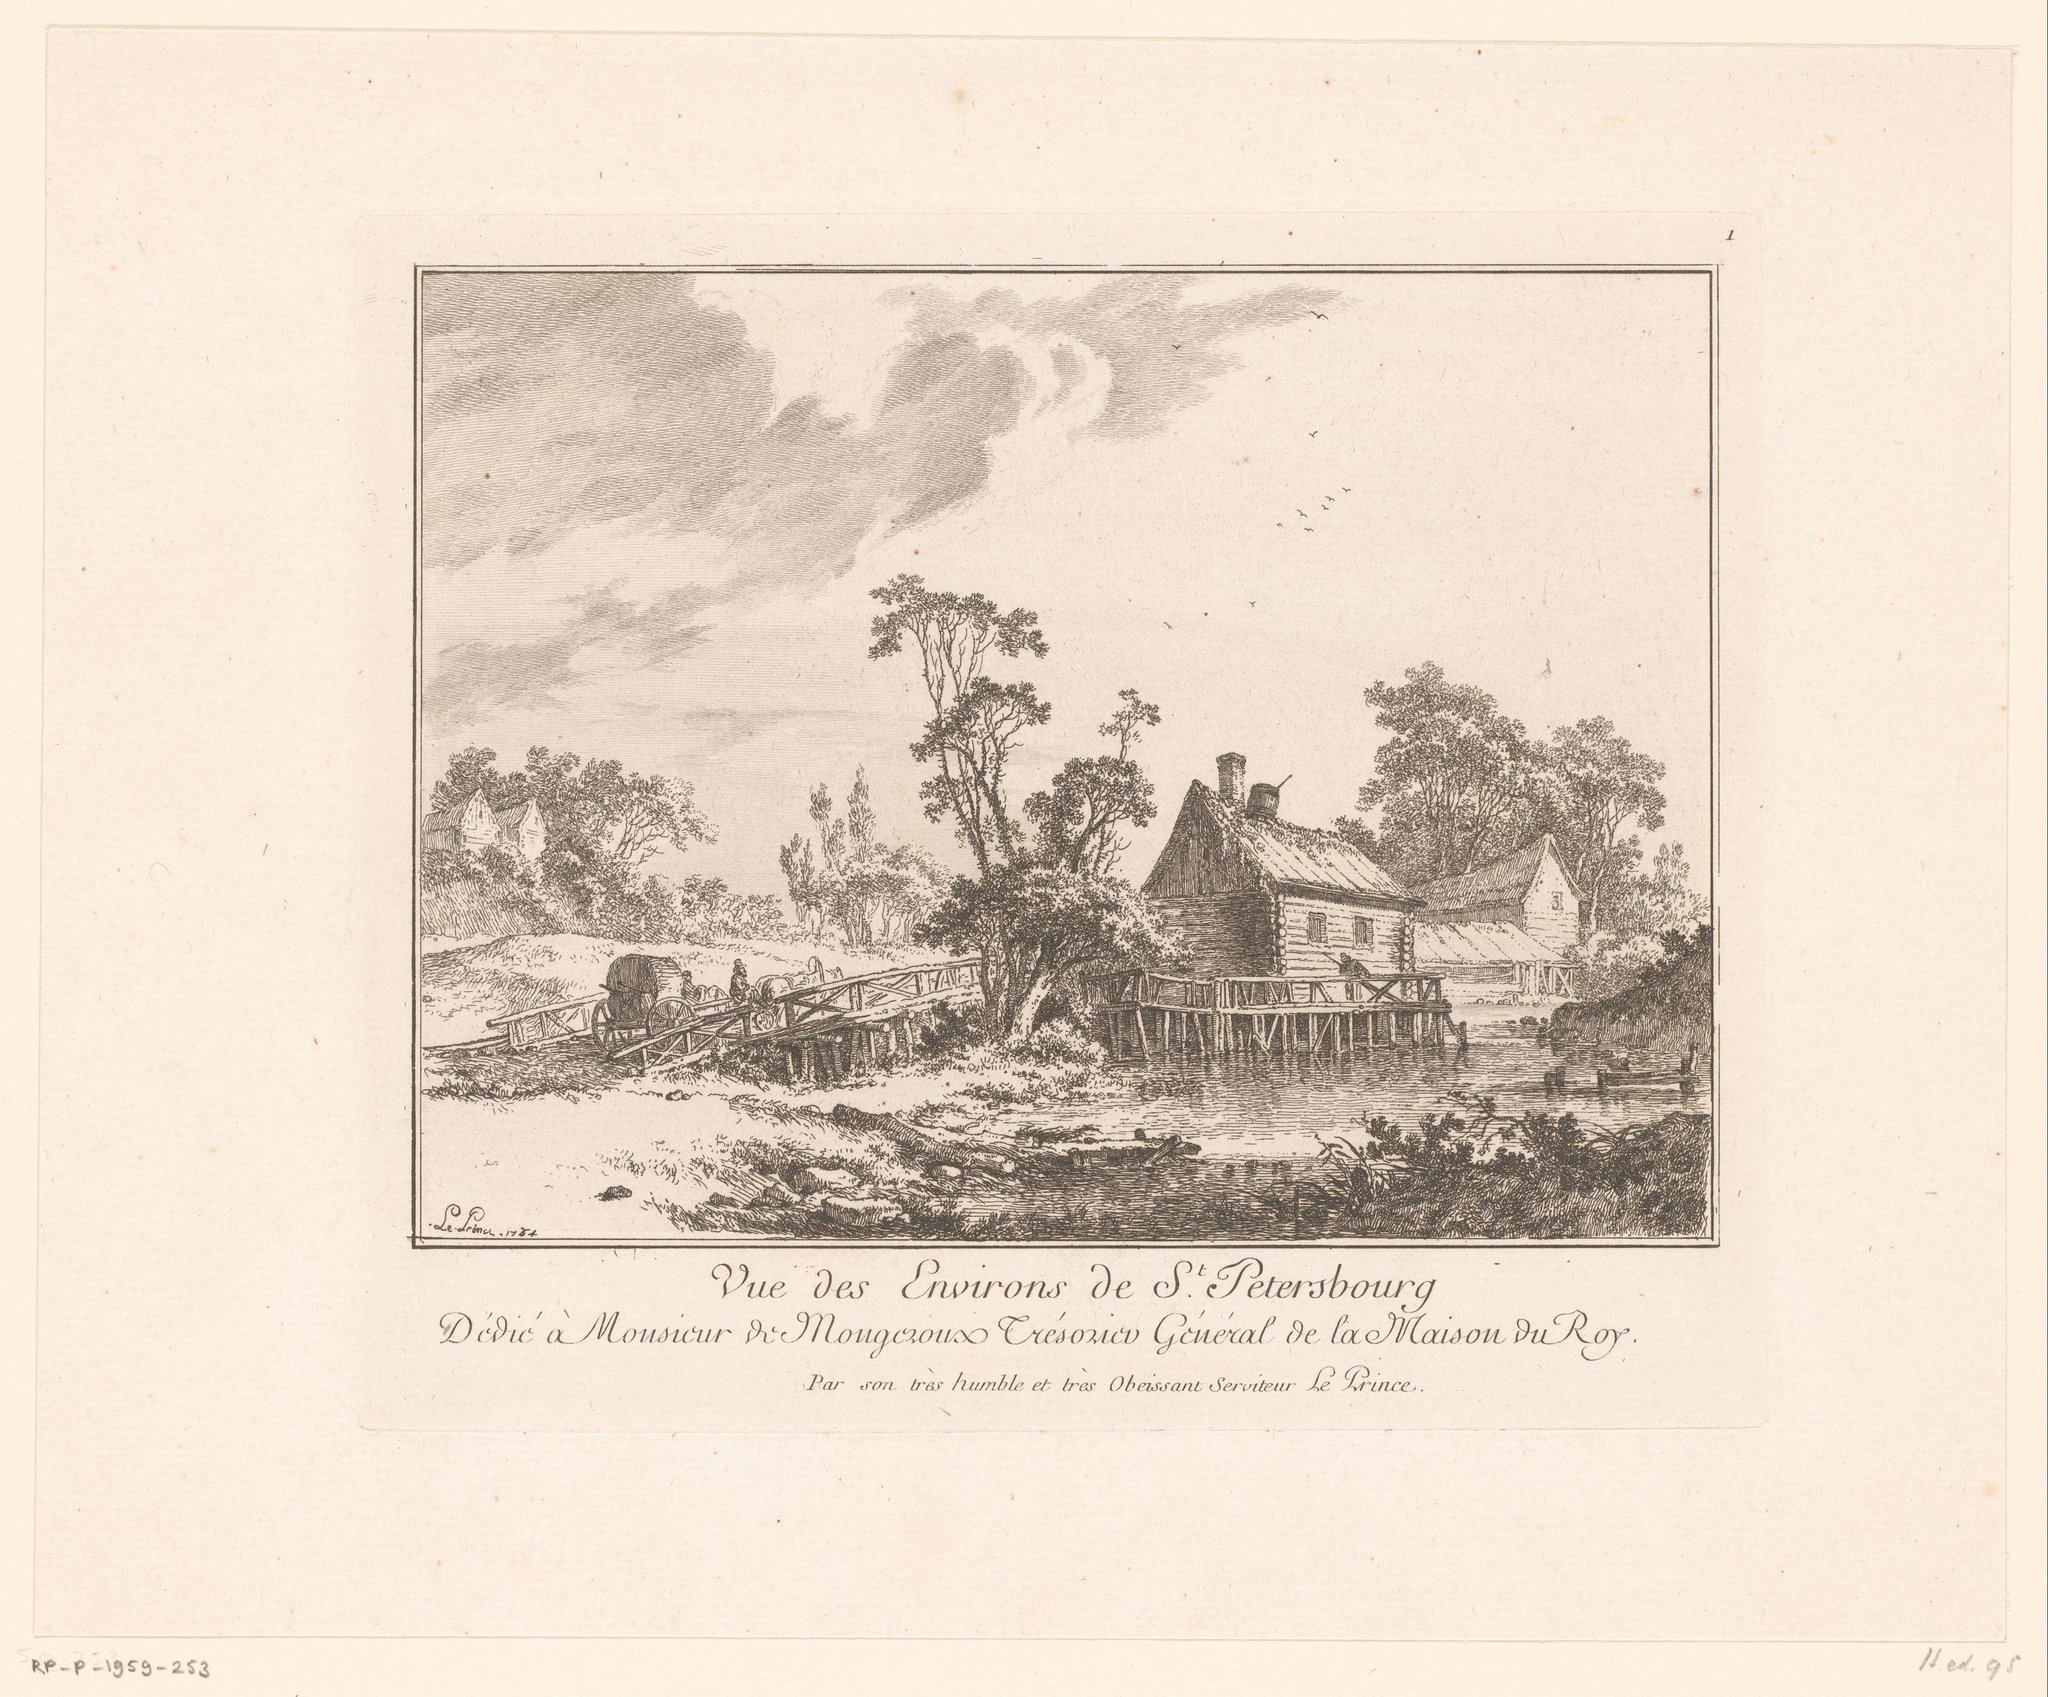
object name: print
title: Vue des Environs de St. Petersbourg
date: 1764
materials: paper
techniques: etching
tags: rural housing, e.g. country-house, villa, cottage, covered wagon, hooded wagon, pier, quay, wharf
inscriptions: collector's mark: Lugt 2228, collector's mark: Lugt 2760